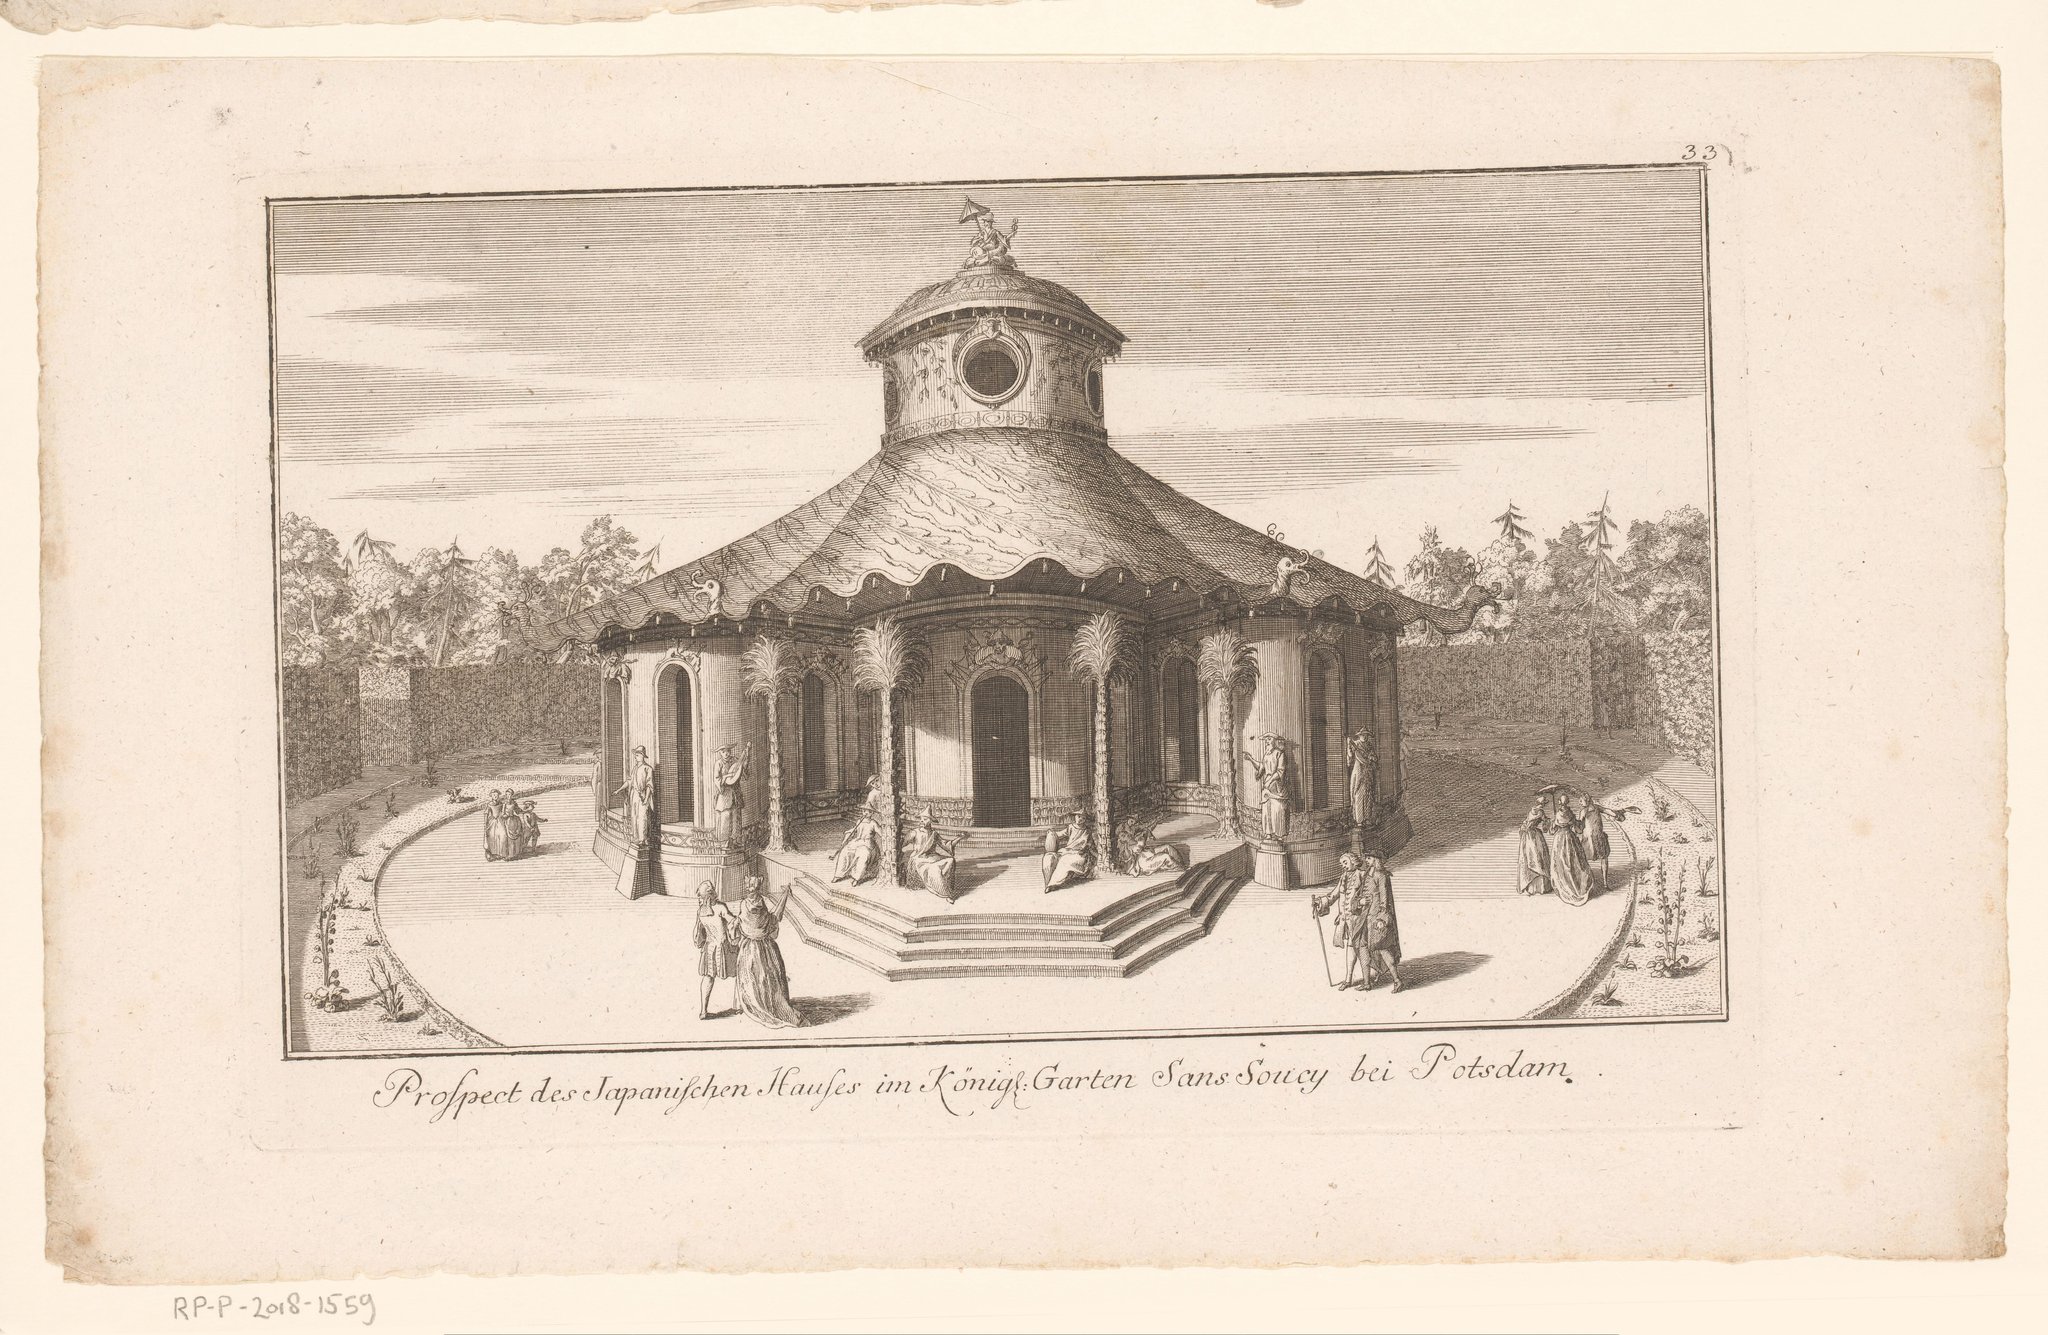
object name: print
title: Prospect des Japanischen Hauses im Königl. Garten Sans-Soucy bei Potsdam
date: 1747-1774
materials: paper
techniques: engraving, etching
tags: castle, french or architectonic garden; formal garden, summer-house, arbour, garden-house (dutch: 'theekoepel')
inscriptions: collector's mark: Lugt 2228